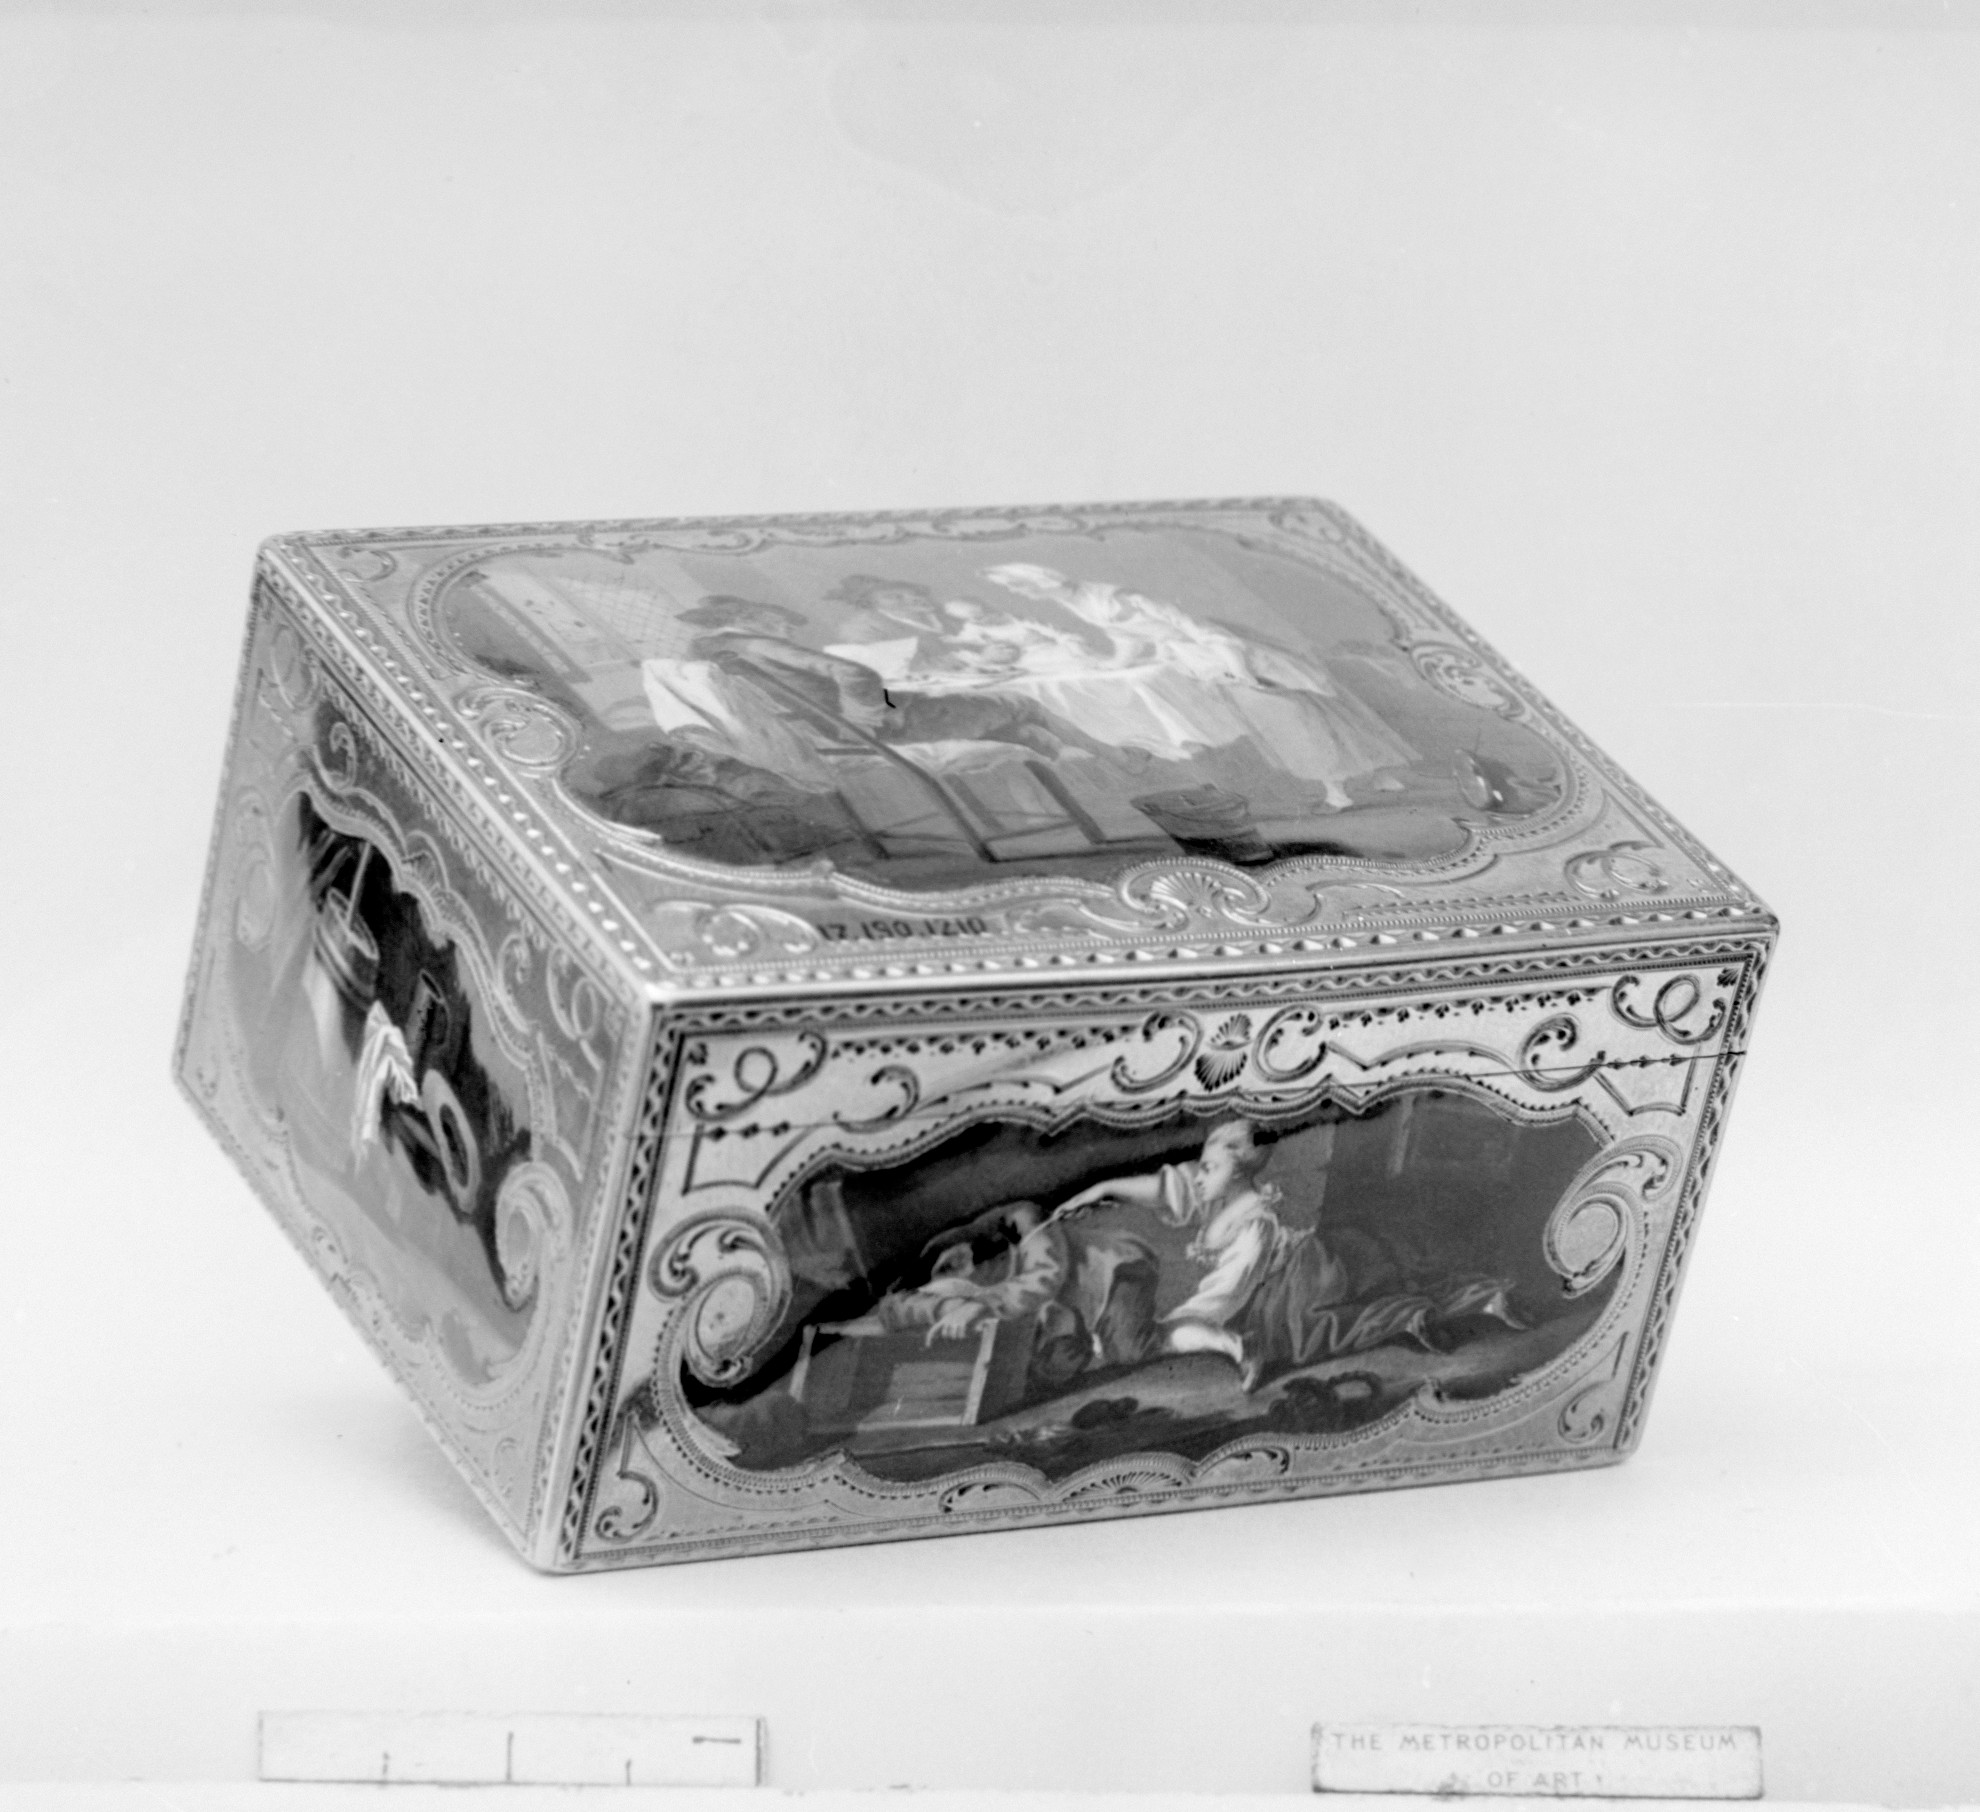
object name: snuffbox, painting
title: Snuffbox with peasant scenes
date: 1760-1761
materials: enamel, gold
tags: men,women